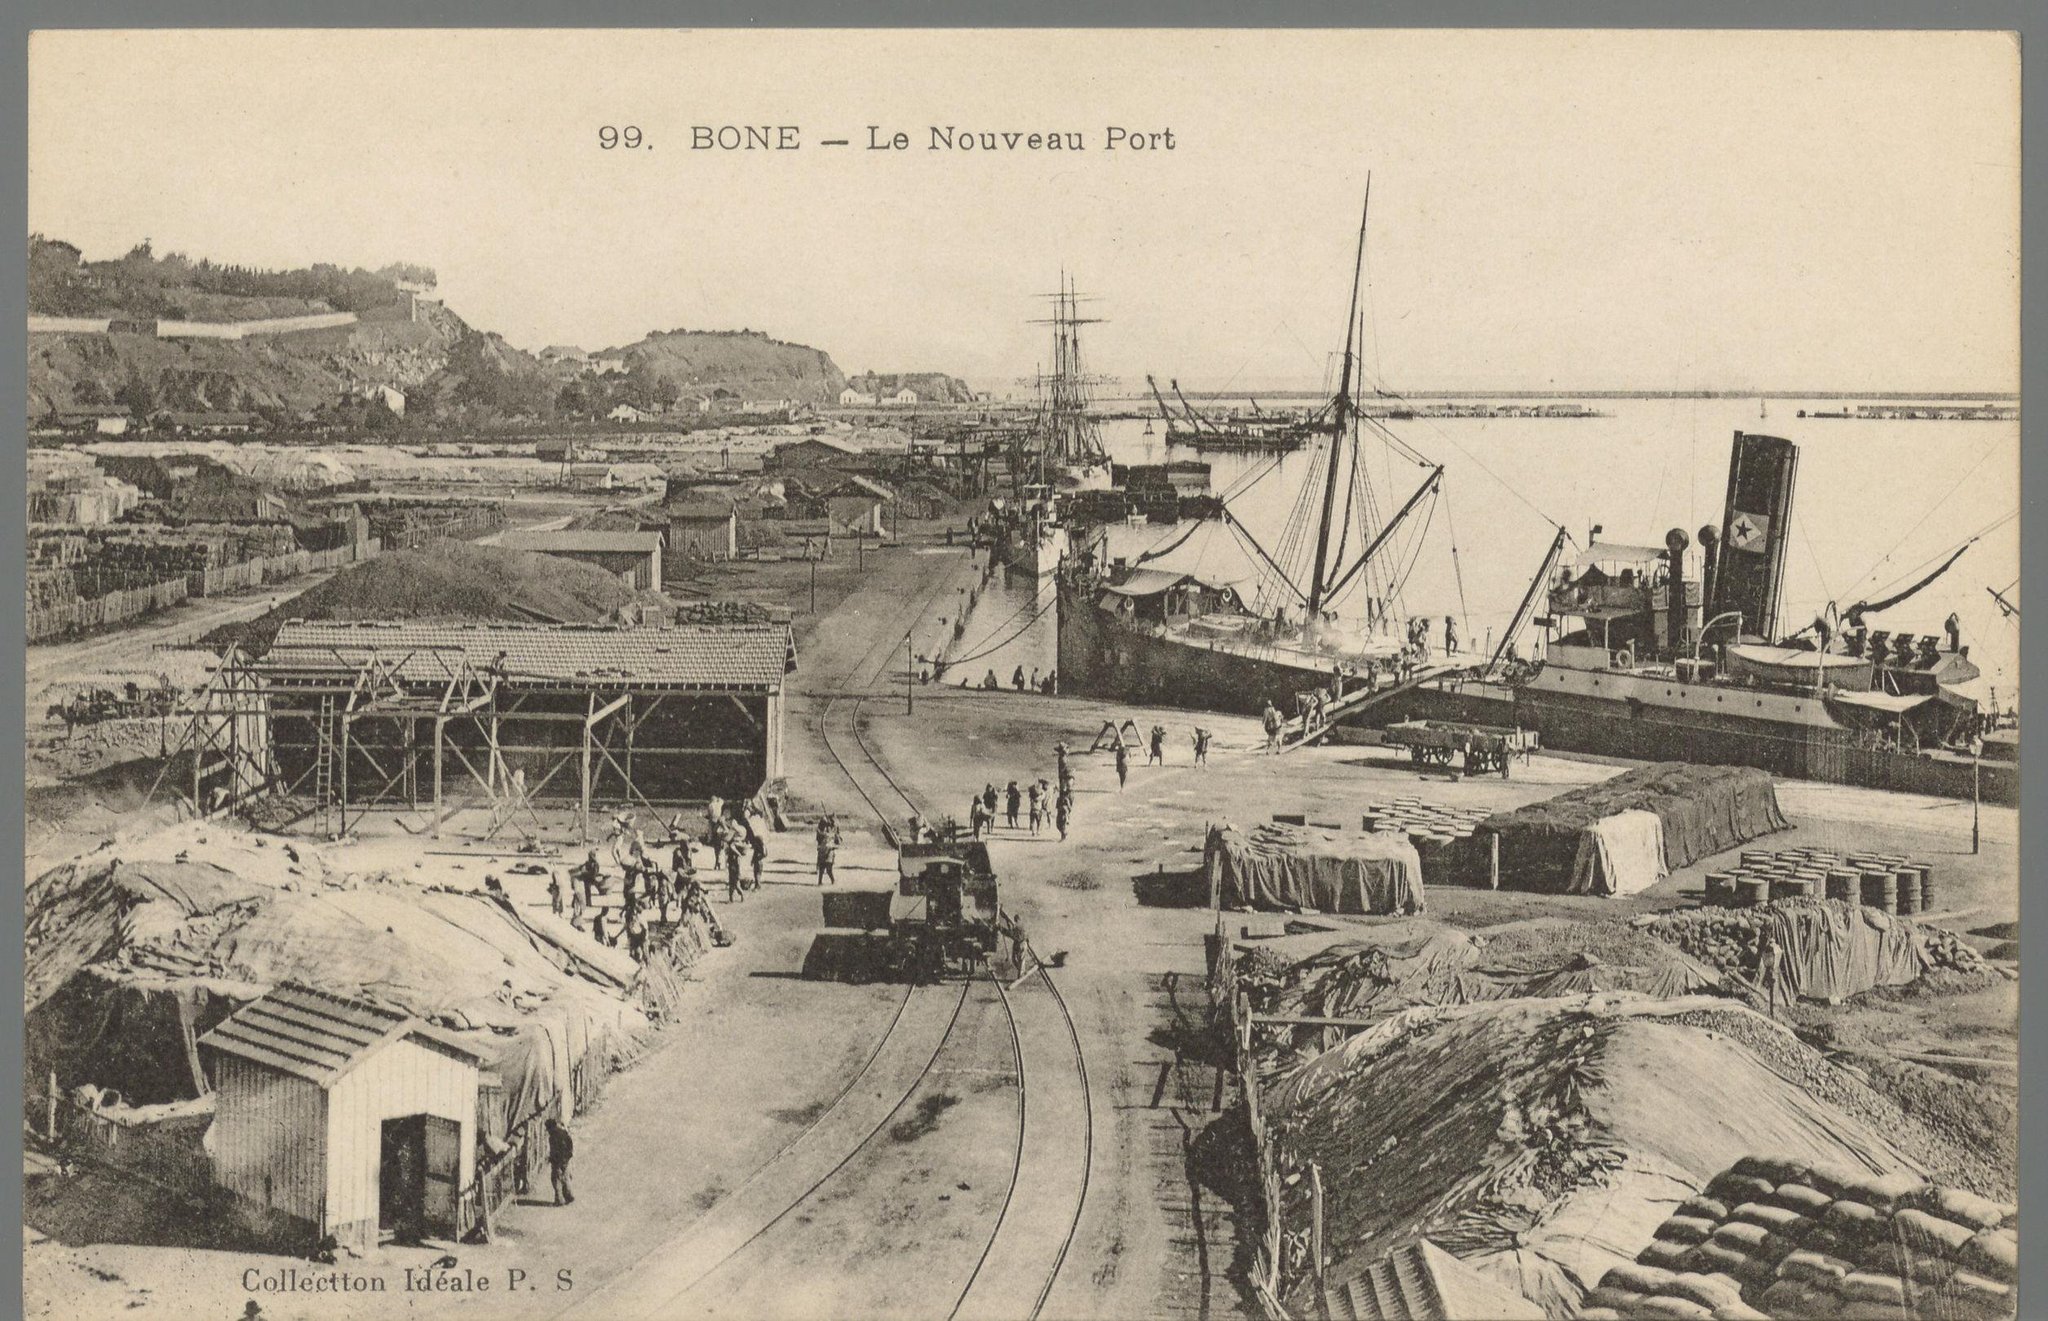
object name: photomechanical print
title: Bone. Le Nouveau Port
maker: paul satragno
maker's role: printer, publisher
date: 1903-1905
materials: cardboard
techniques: photograph, writing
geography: algiers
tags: harbour, ships (in general), building-site